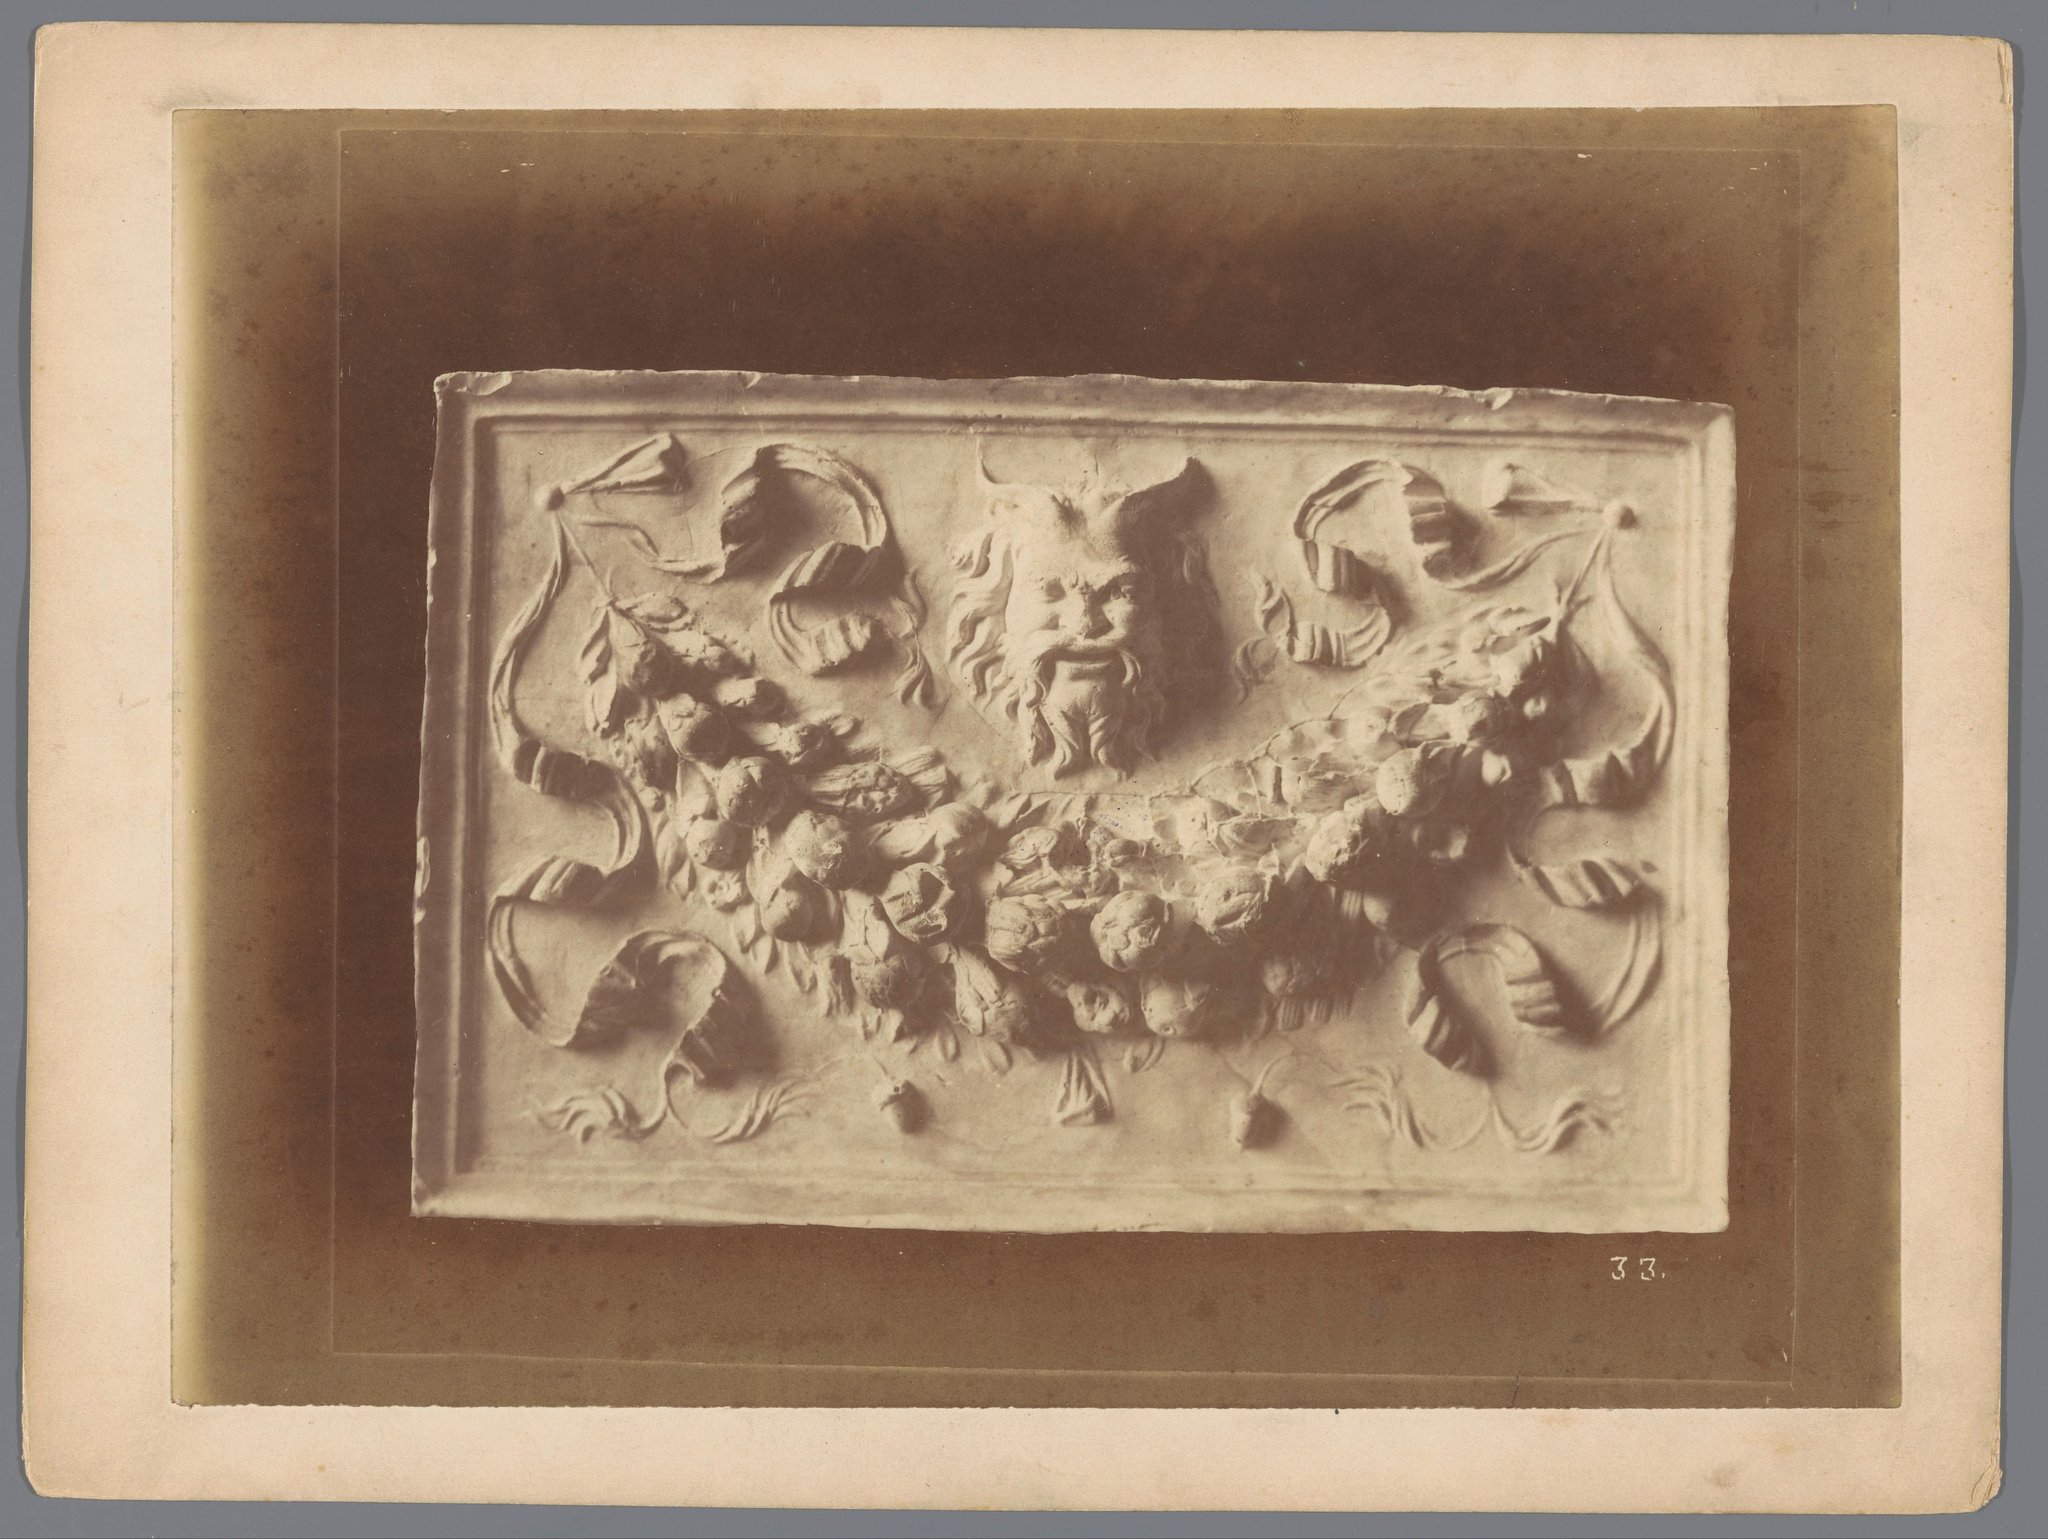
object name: photograph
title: Reliëf met een guirlande en een maskerkop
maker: gustave eugène chauffourier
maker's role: fotograaf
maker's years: 1845-1919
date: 1875-1900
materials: photographic support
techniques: albumen print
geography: italy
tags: garland, wreath, mask, mascaron ~ ornament, sculpture (+ relief ~ sculpture)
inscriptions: collector's mark: Lugt 3937, number: ‘33’